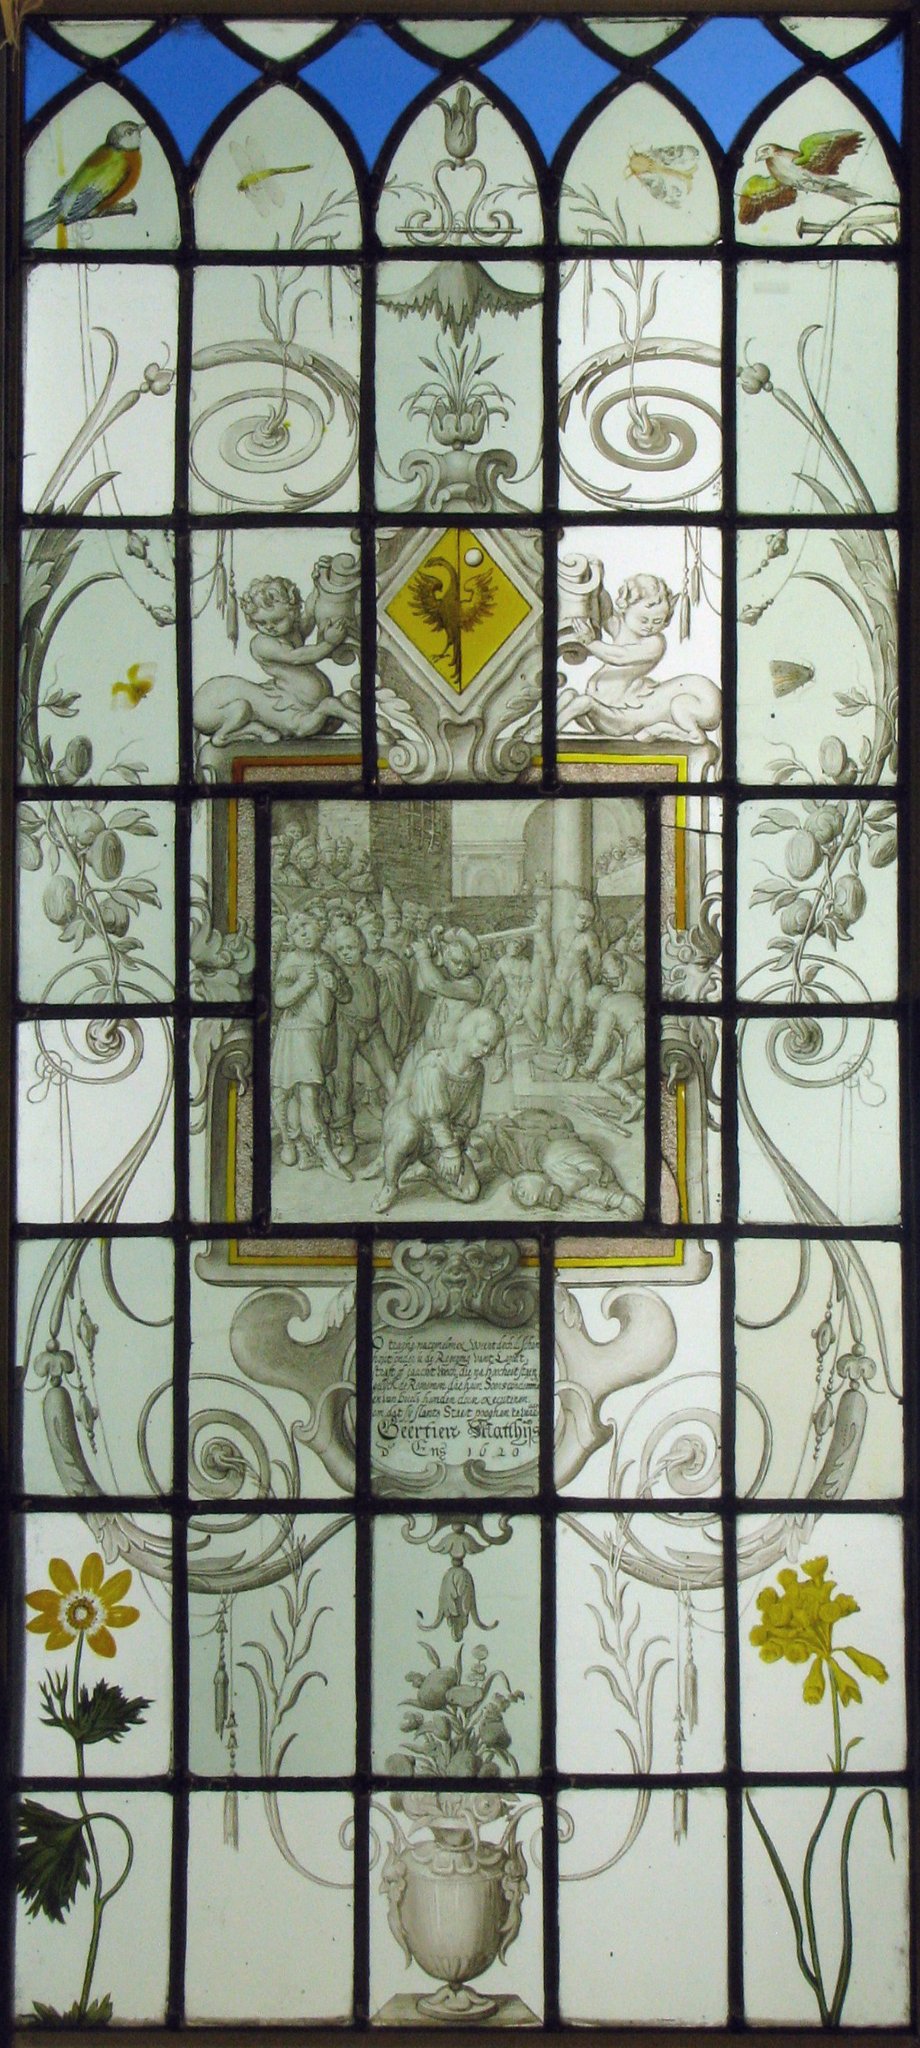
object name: window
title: The Beheading of Roman Sons (one of two)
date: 1620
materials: glass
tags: birds,swords,men,coat of arms